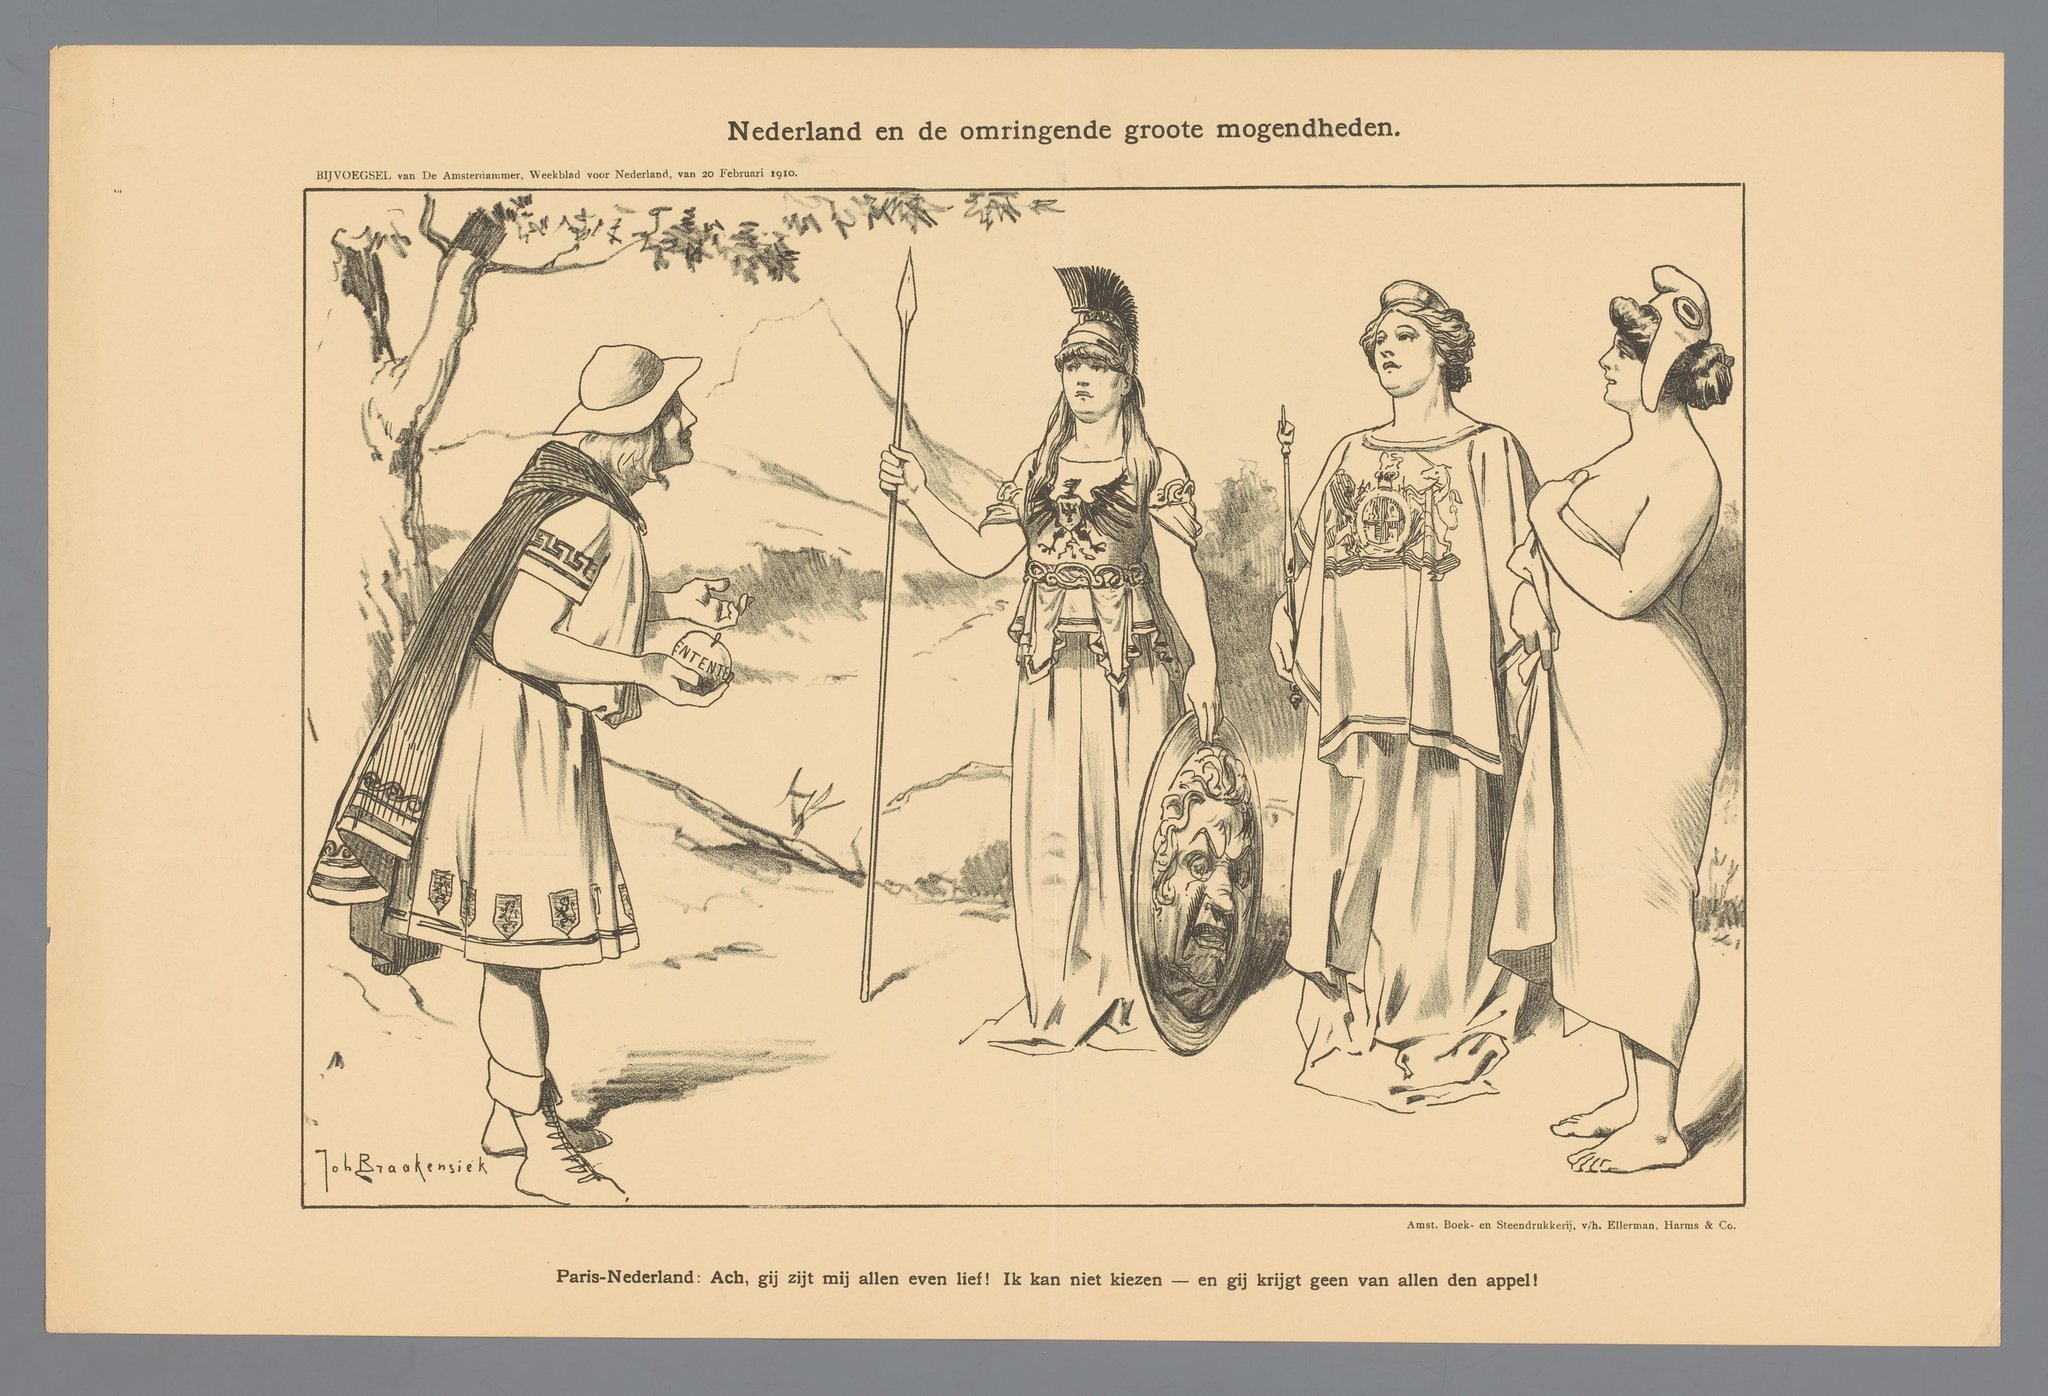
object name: cartoon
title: Nederland en de omringende groote mogendheden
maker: johan braakensiek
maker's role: draughtsman, print maker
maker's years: 1858-1940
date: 1910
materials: paper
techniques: lithograph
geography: amsterdam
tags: the judgement of paris (without mercury), personifications of countries, nations, states, districts, etc. (+ nation; national), political caricatures and satires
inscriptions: date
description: Prent uit het bijvoegsel van: De Amsterdammer. Weekblad voor Nederland, 20 februari 1910.